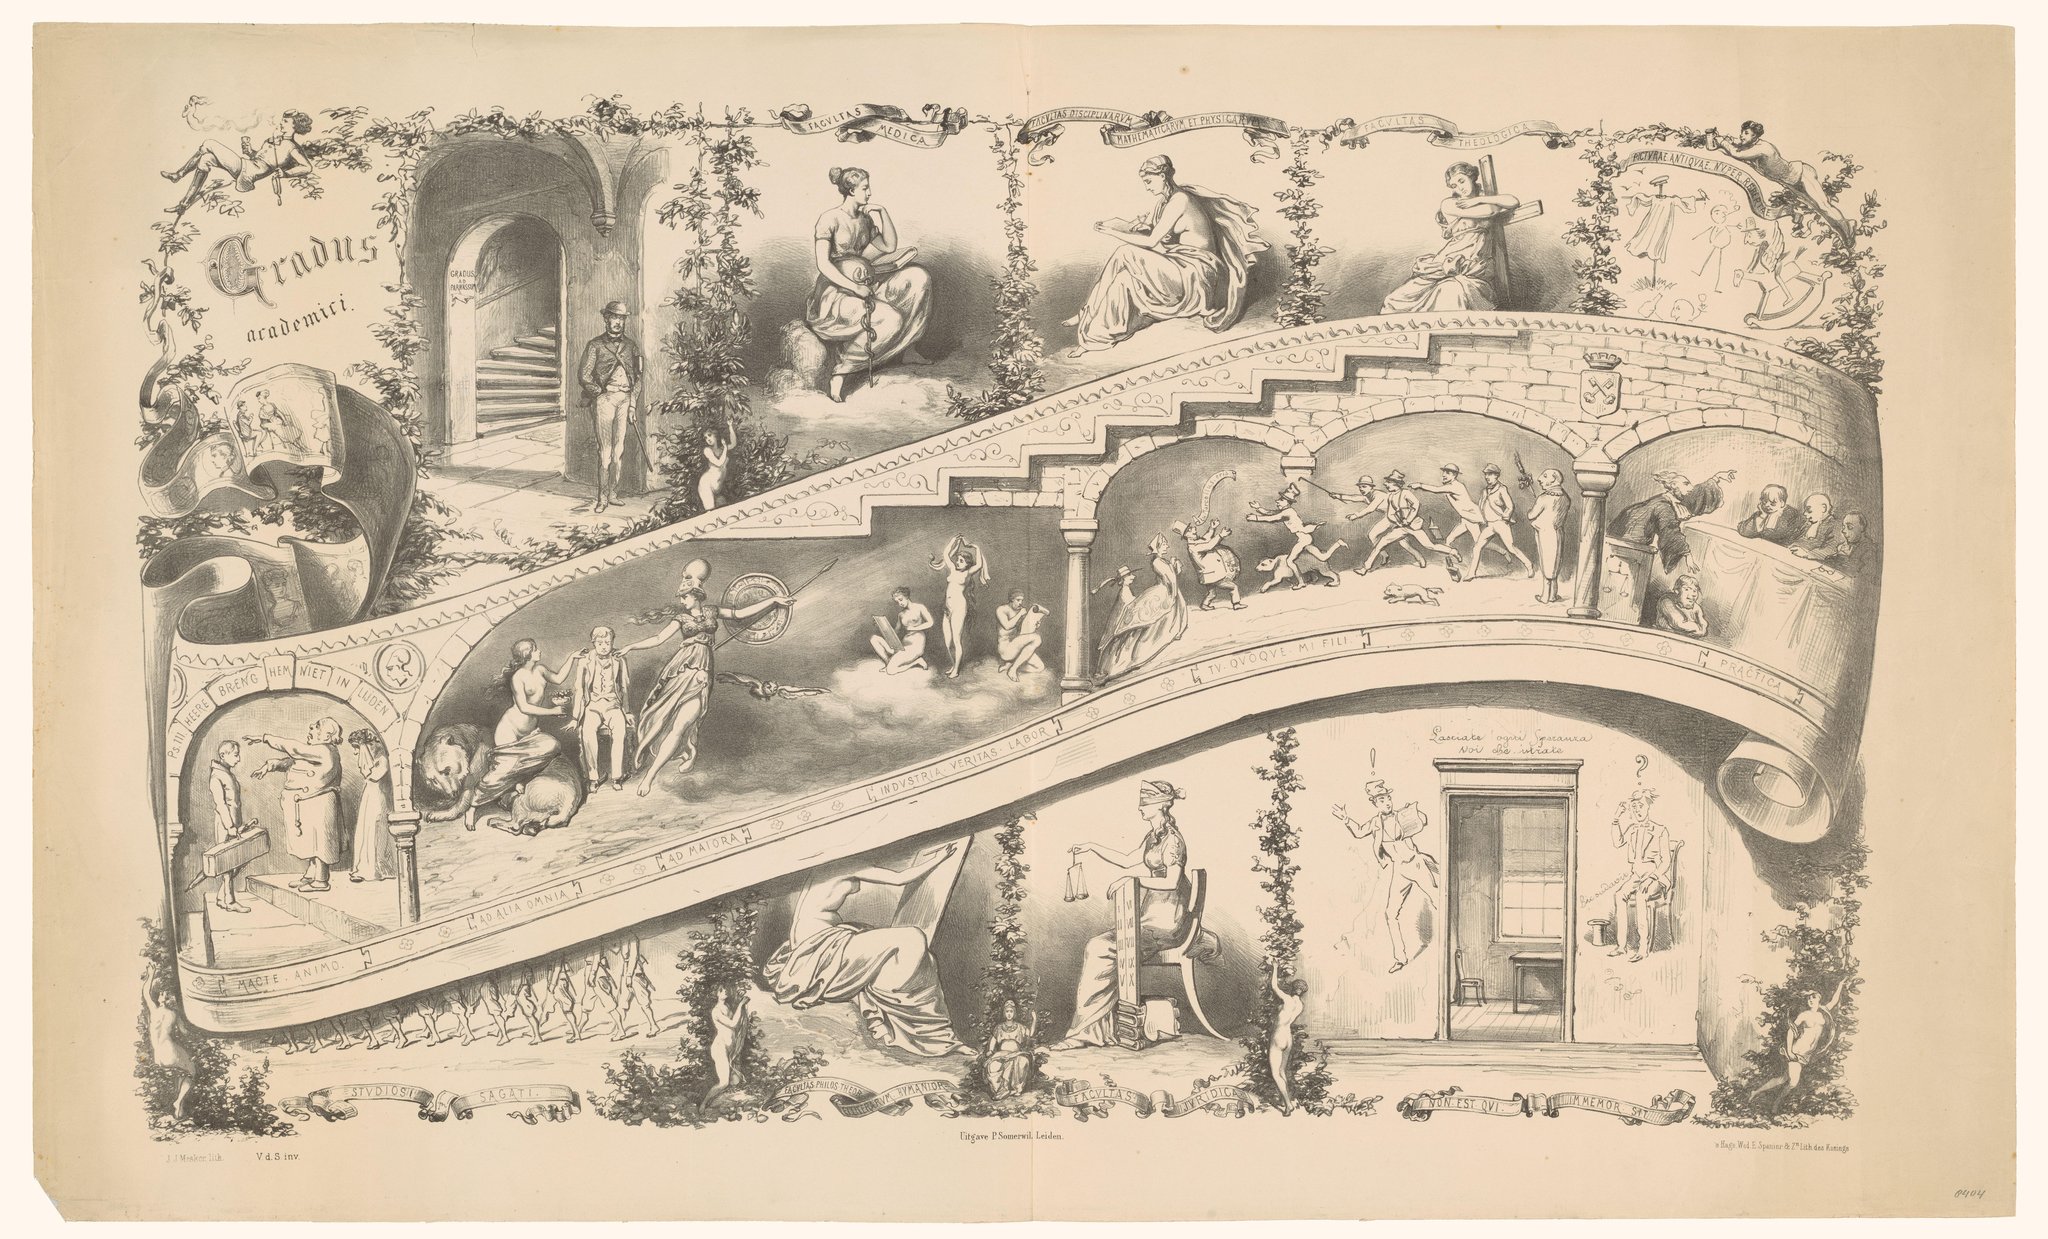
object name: print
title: Voorstelling van de loopbaan van een Leidse student, 1871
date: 1871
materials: paper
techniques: lithograph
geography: leiden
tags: students' organization, student life, leiden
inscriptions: collector's mark: Lugt 2228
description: Voorstelling van de loopbaan van een Leidse student vanaf zijn aankomst op de academie tot aan zijn promotie. 1871. Centraal een banderol met komische schetsen uit het studentenleven. Bovenaan drie en onderaan twee faculteiten voorgesteld door allegorische vrouwenfiguren. Linksboven de ingang van de stenen trap van het Academiegebouw in Leiden, rechtsonder het beruchte zweetkamertje.